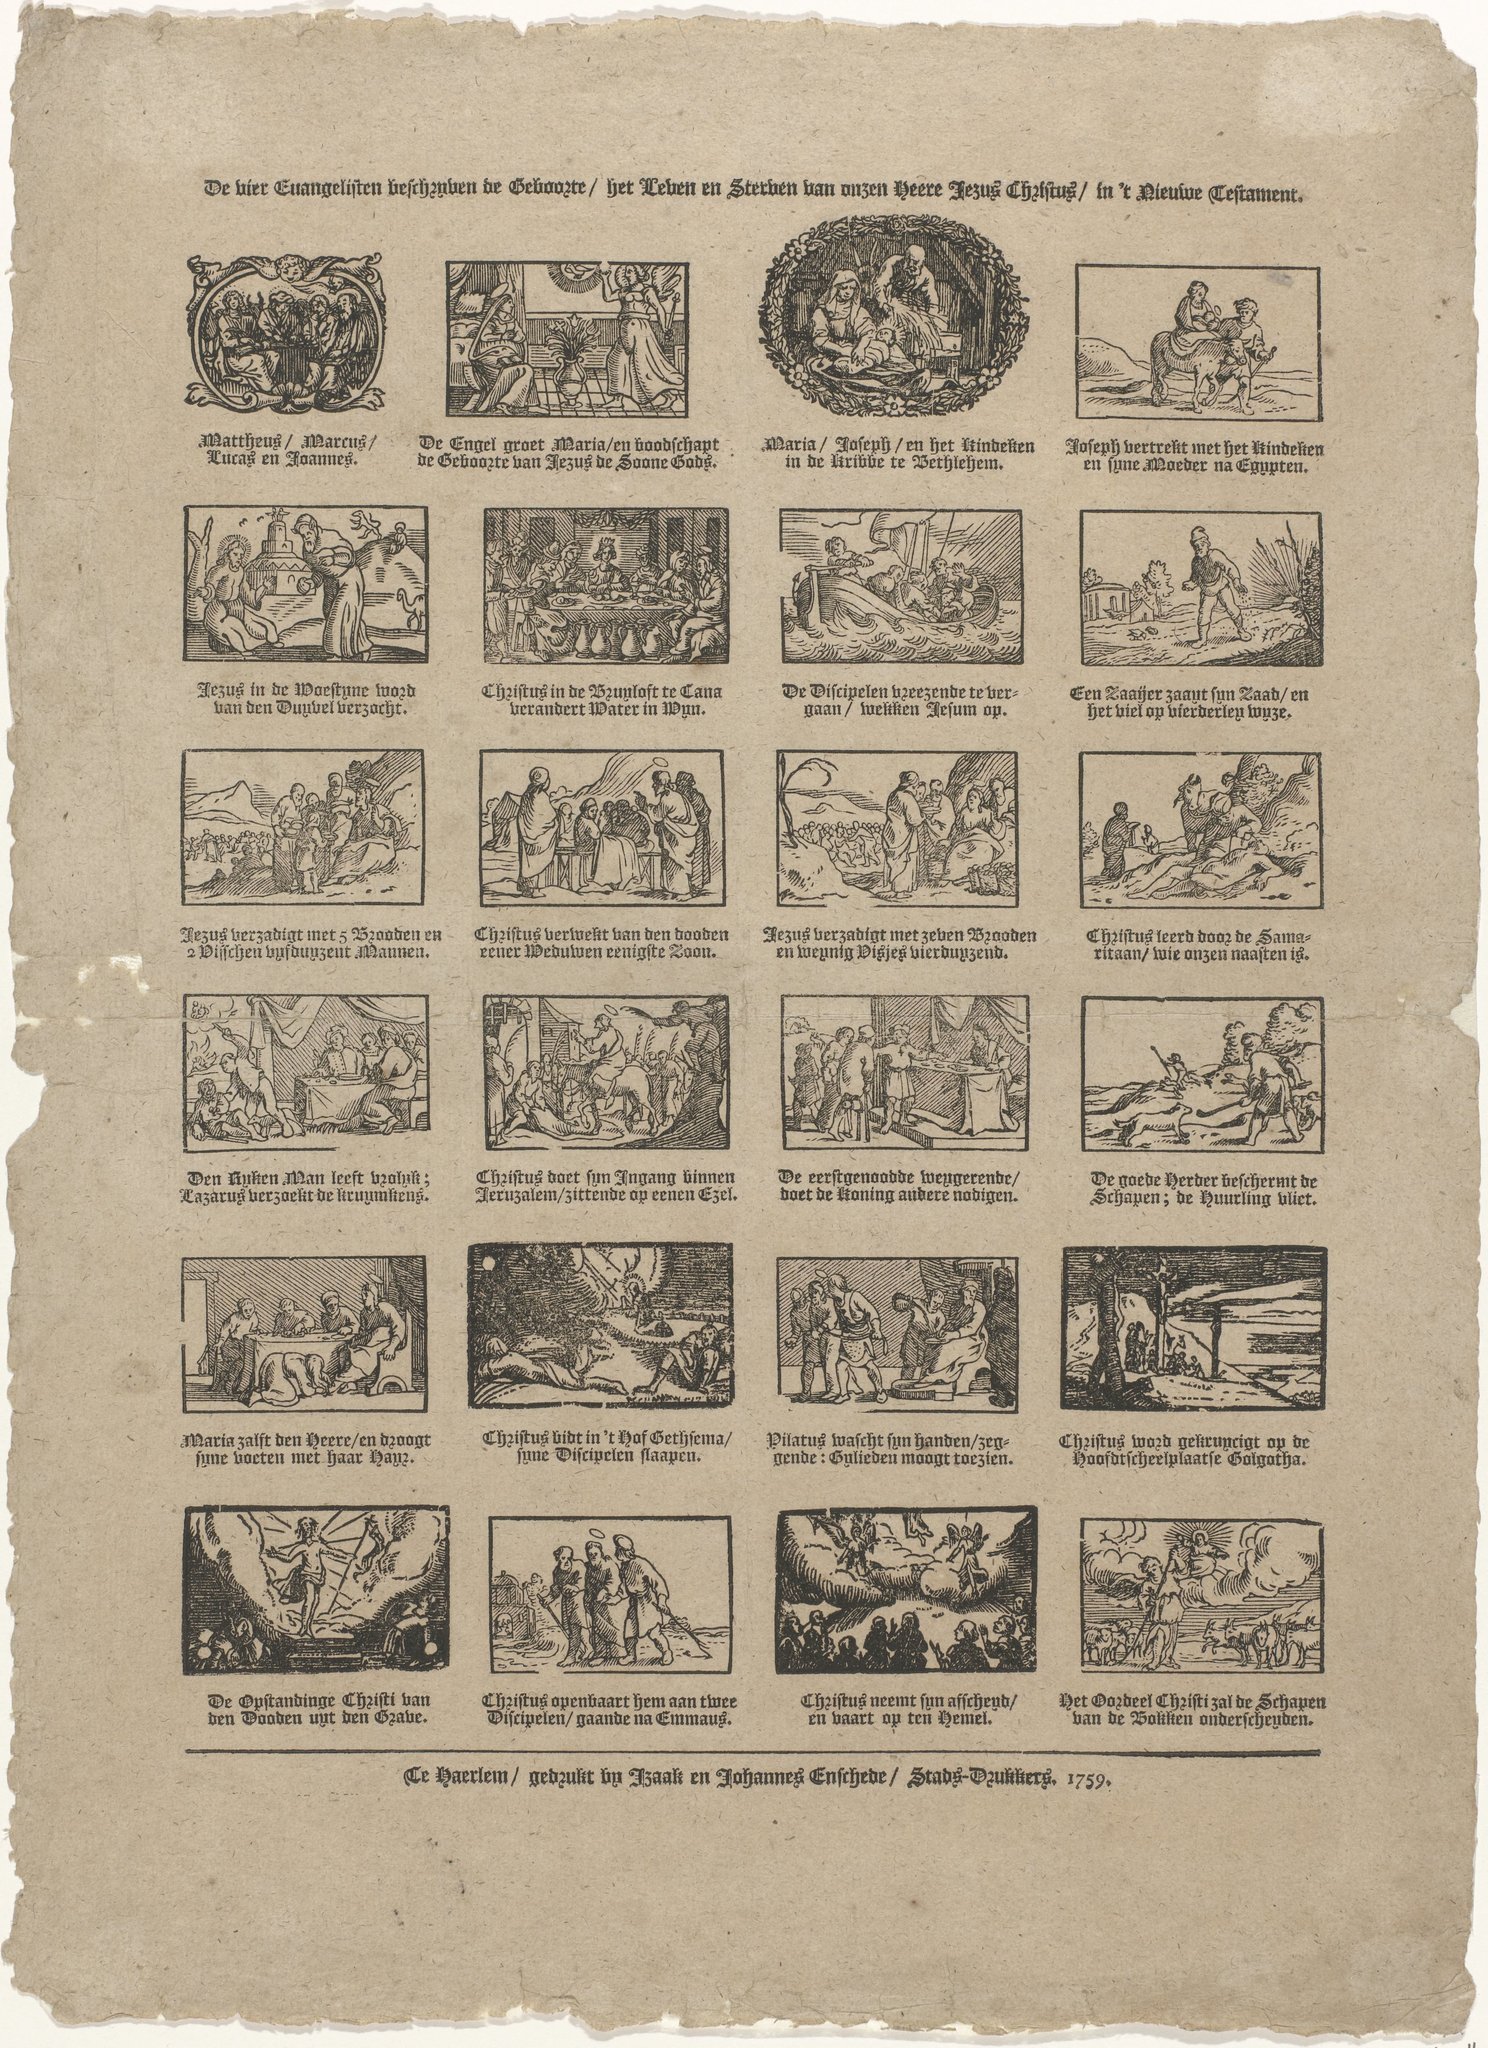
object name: print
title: De vier evangelisten beschryven de geboorte / het leven en sterven van onzen heere Jezus Christus / in 't Nieuwe Testament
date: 1759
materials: paper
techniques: letterpress printing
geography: haarlem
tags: (scenes from the life of) john the baptist and mary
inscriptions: collector's mark: Lugt 2760, collector's mark: Lugt 2228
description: Blad met 24 voorstellingen van verhalen uit het Nieuwe Testament, zoals de geboorte, de vlucht naar Egypte, Jezus in de woestijn en de intocht in Jeruzalem. Onder elke afbeelding een tweeregelig vers.